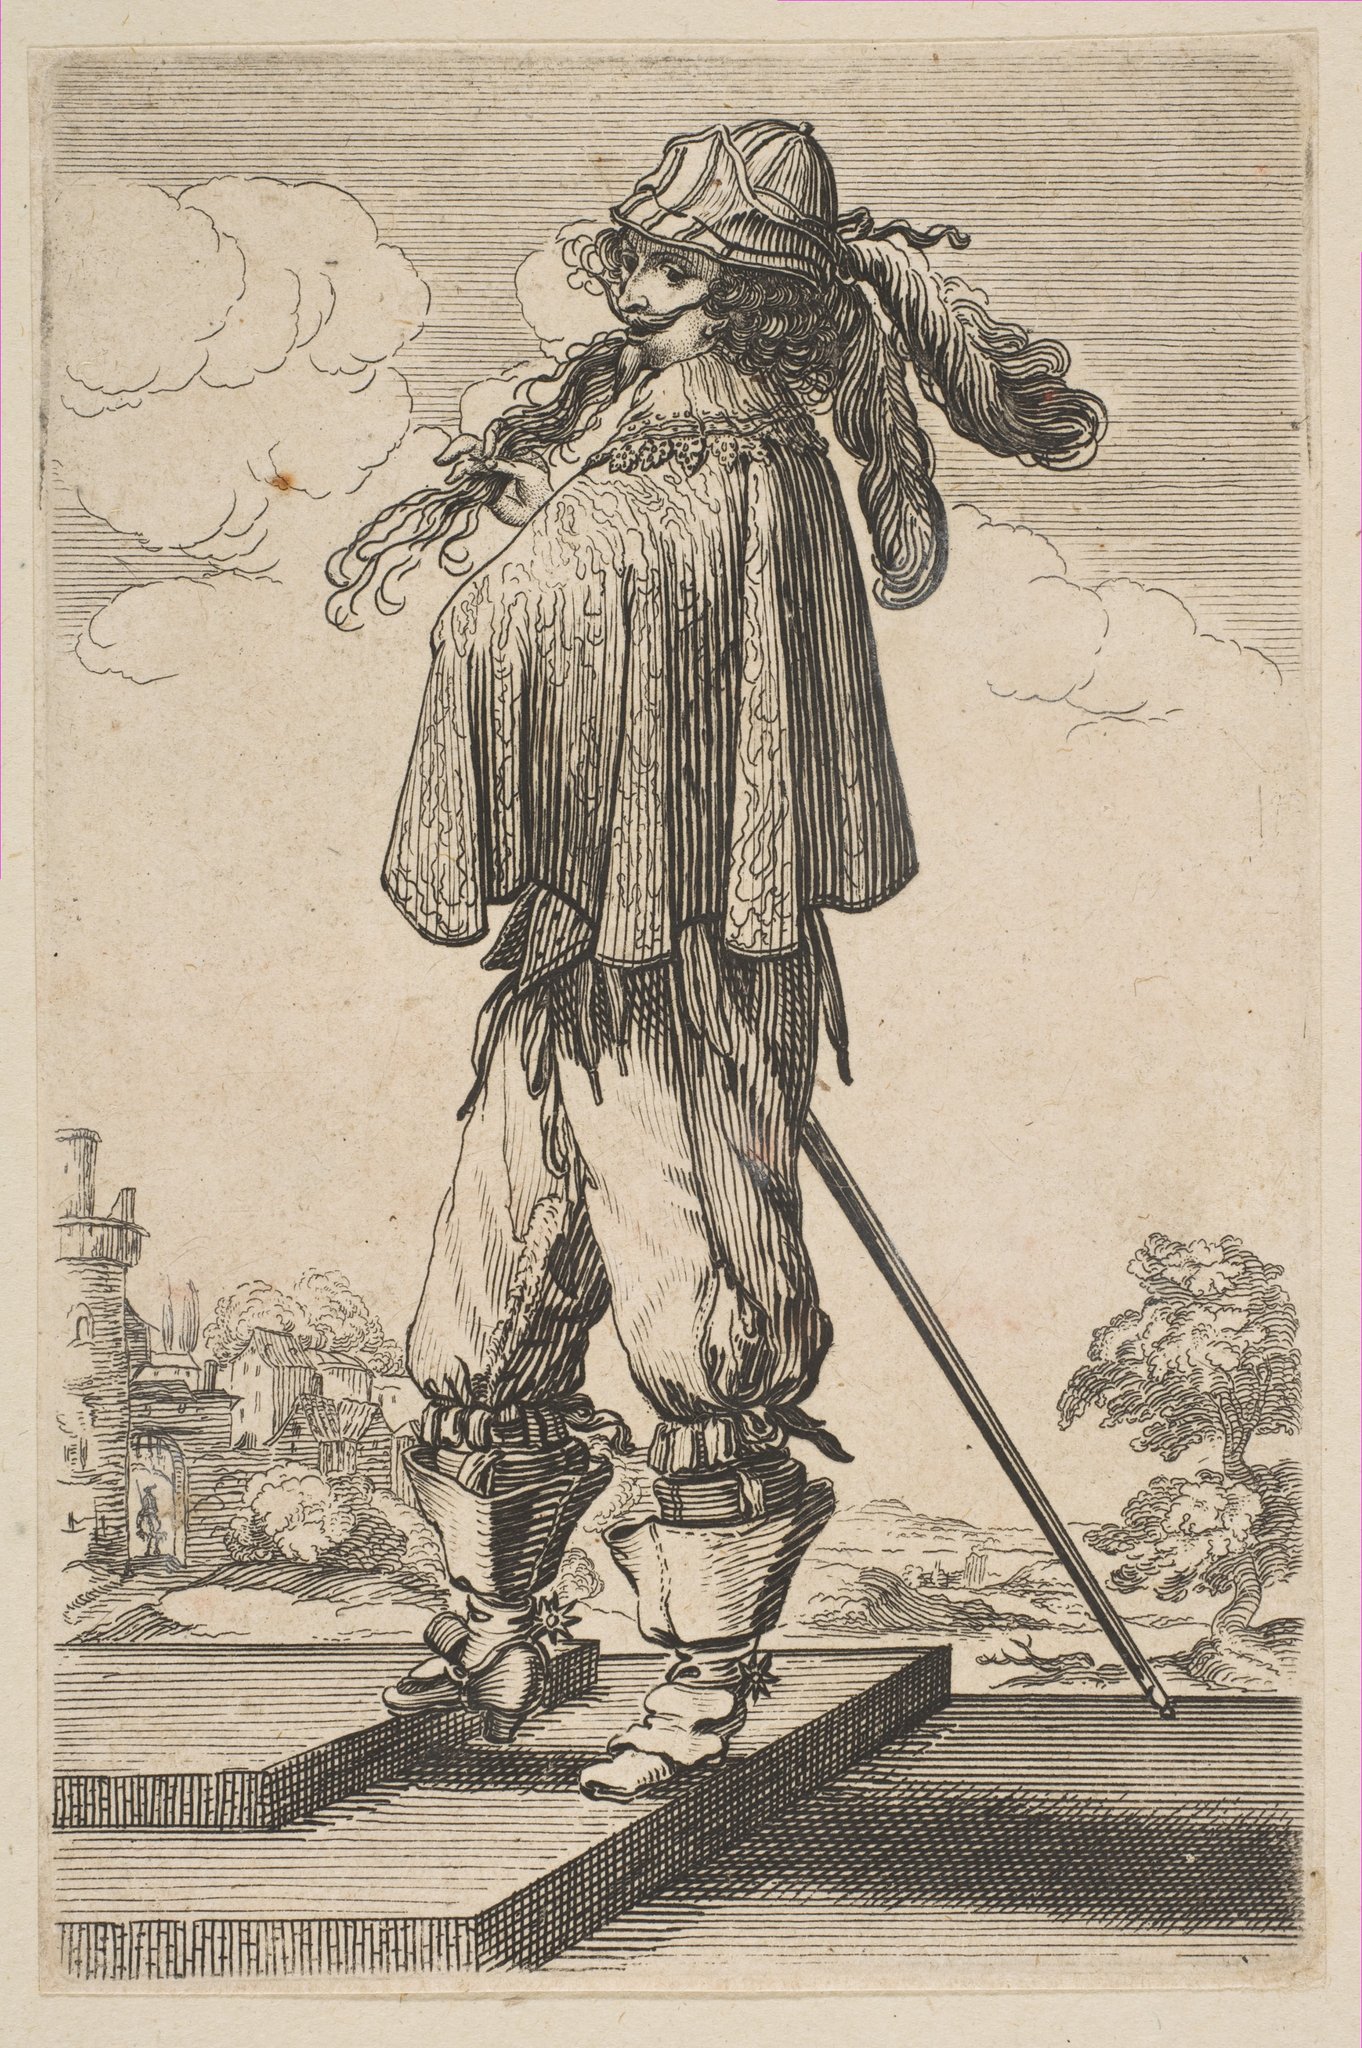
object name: print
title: A Gentleman Mounts a Step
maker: anonymous, french, 17th century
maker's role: artist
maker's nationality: french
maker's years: 1600-1700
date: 1629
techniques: etching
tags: men,portraits